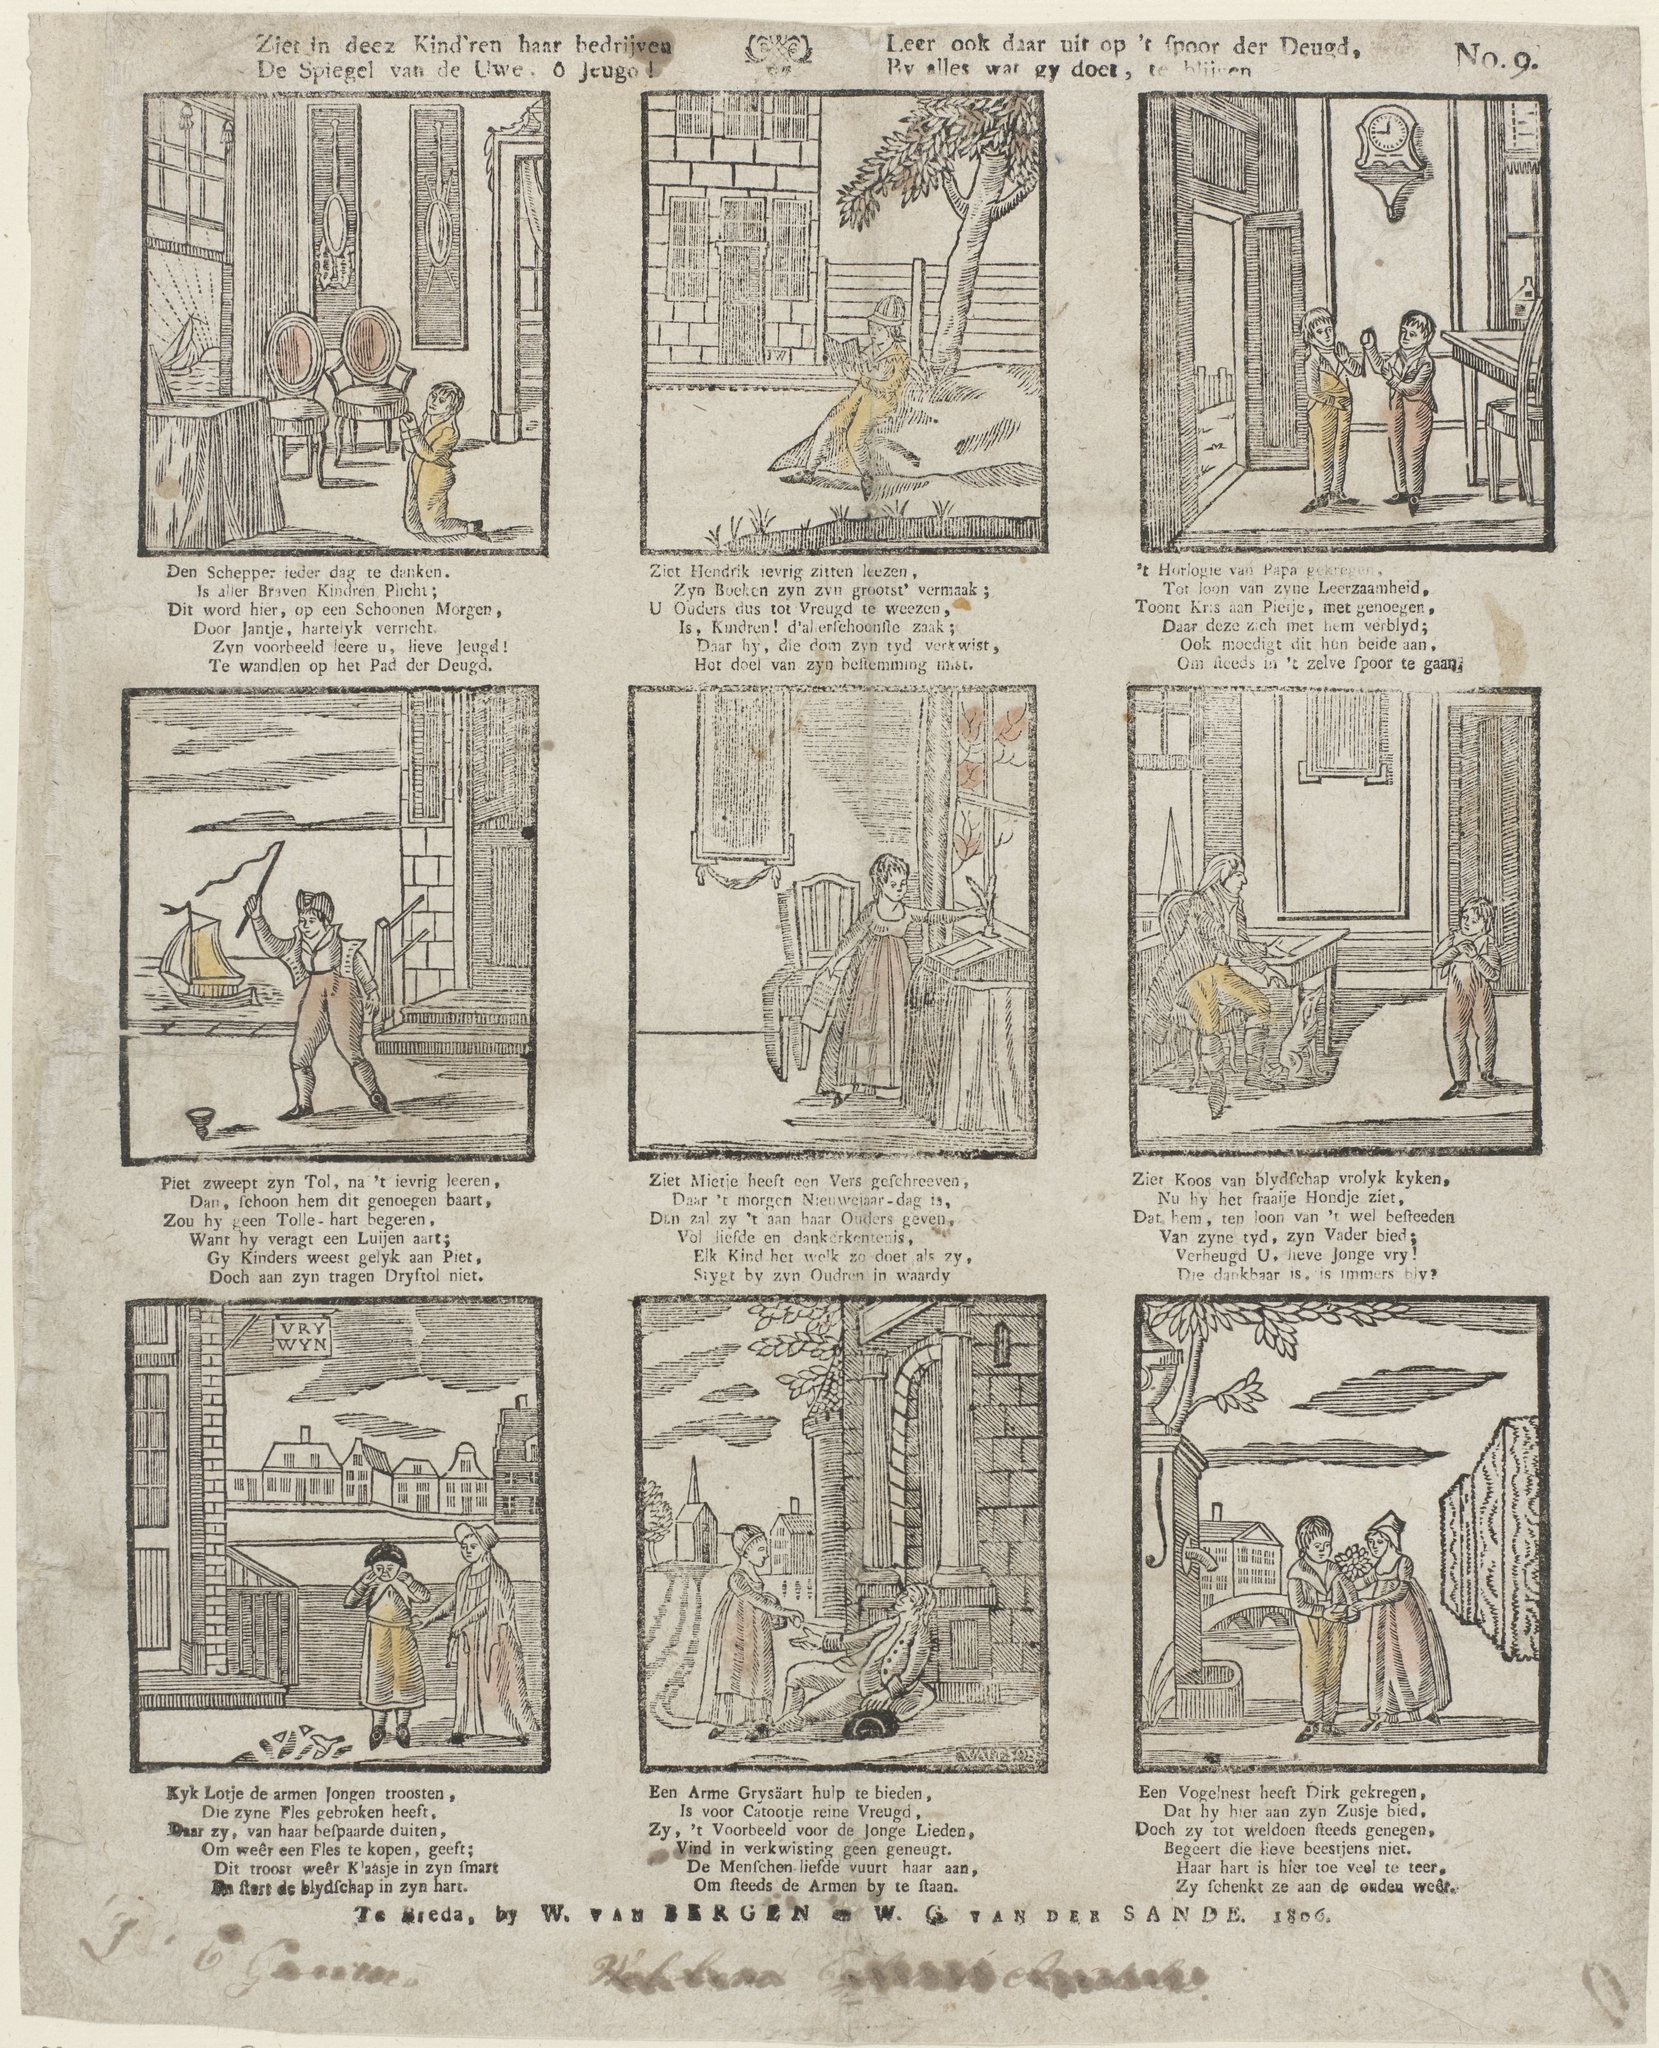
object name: popular print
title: Ziet in deez kind'ren haar bedrijven / De spiegel van de uwe. o jeugd! / Leer ook daar uit op 't spoor der Deugd, / By alles wat gy doet, te blijven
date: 1806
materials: paper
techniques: colour, letterpress printing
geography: breda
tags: children's games and plays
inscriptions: collector's mark: Lugt 2760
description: Blad met 9 voorstellingen van kinderen die worden beloond voor deugdzaam gedrag. Onder elke afbeelding een zesregelig vers. Genummerd rechtsboven: No. 9.